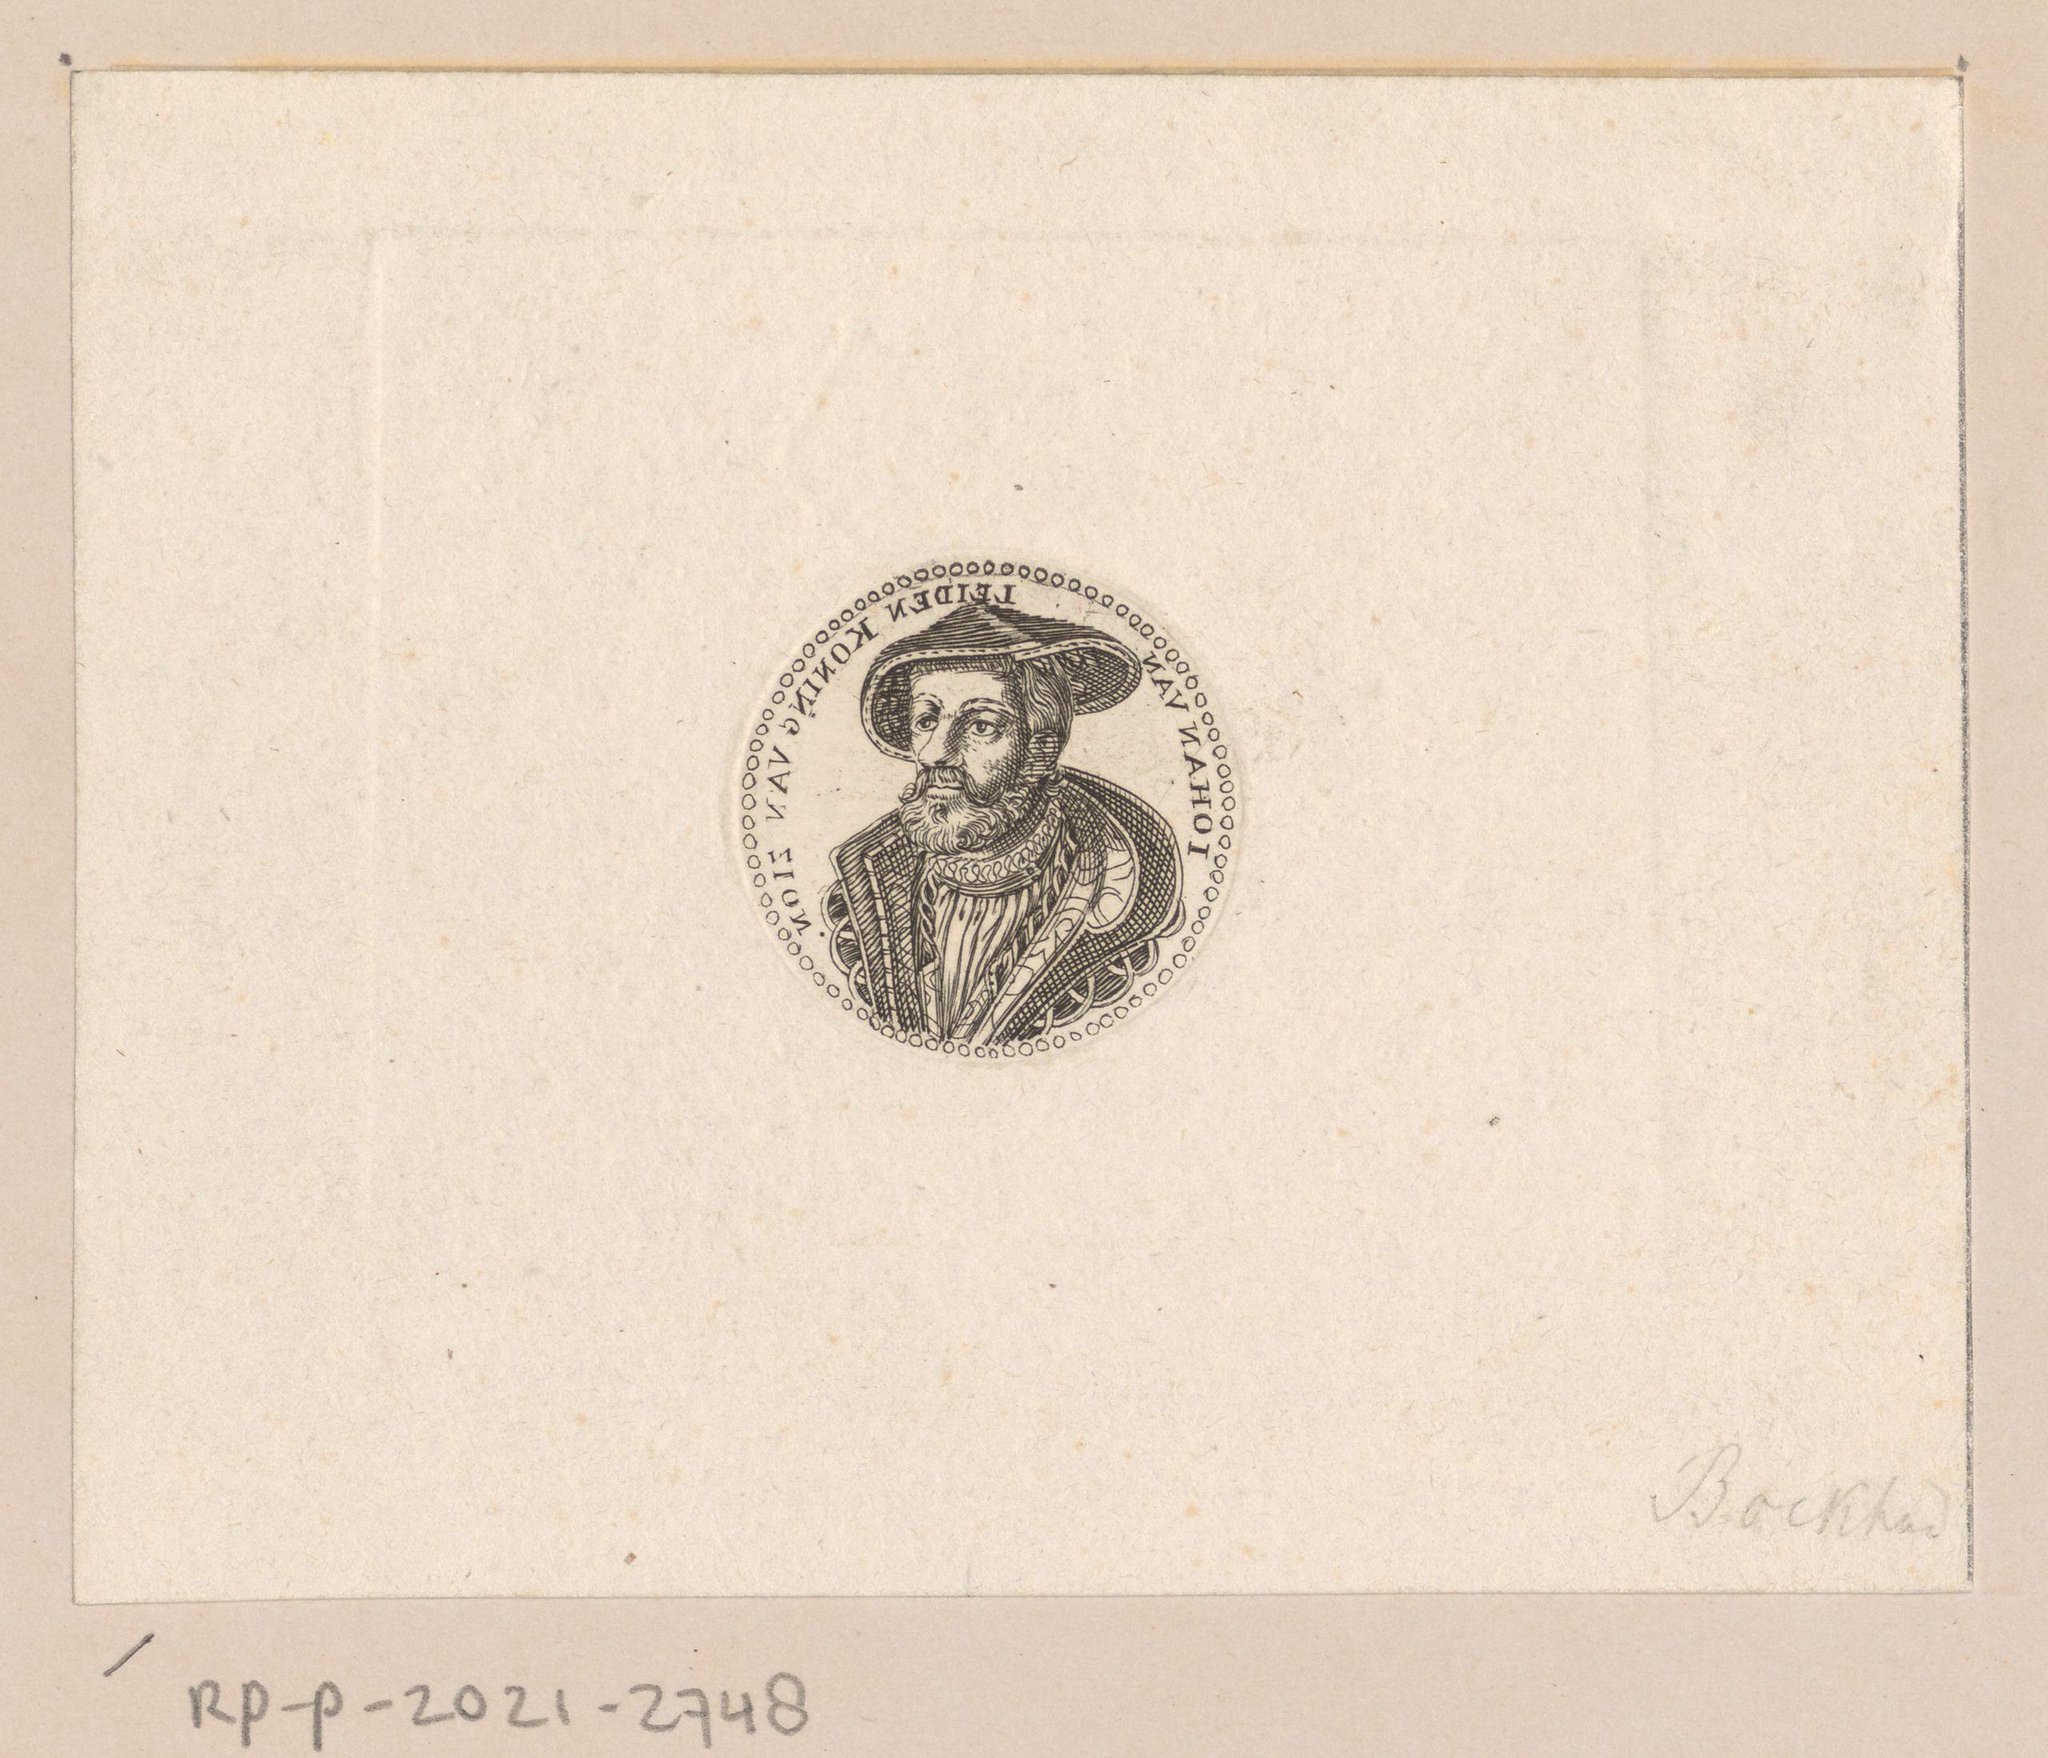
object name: print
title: Penning met het portret van Jan van Leiden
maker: Anonymous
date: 1700-1799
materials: paper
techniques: engraving, etching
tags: leiden, historical persons, coin